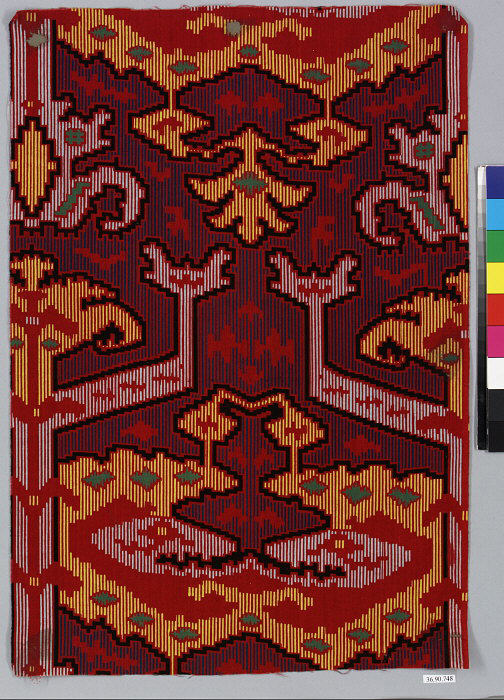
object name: piece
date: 1867-1900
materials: cotton